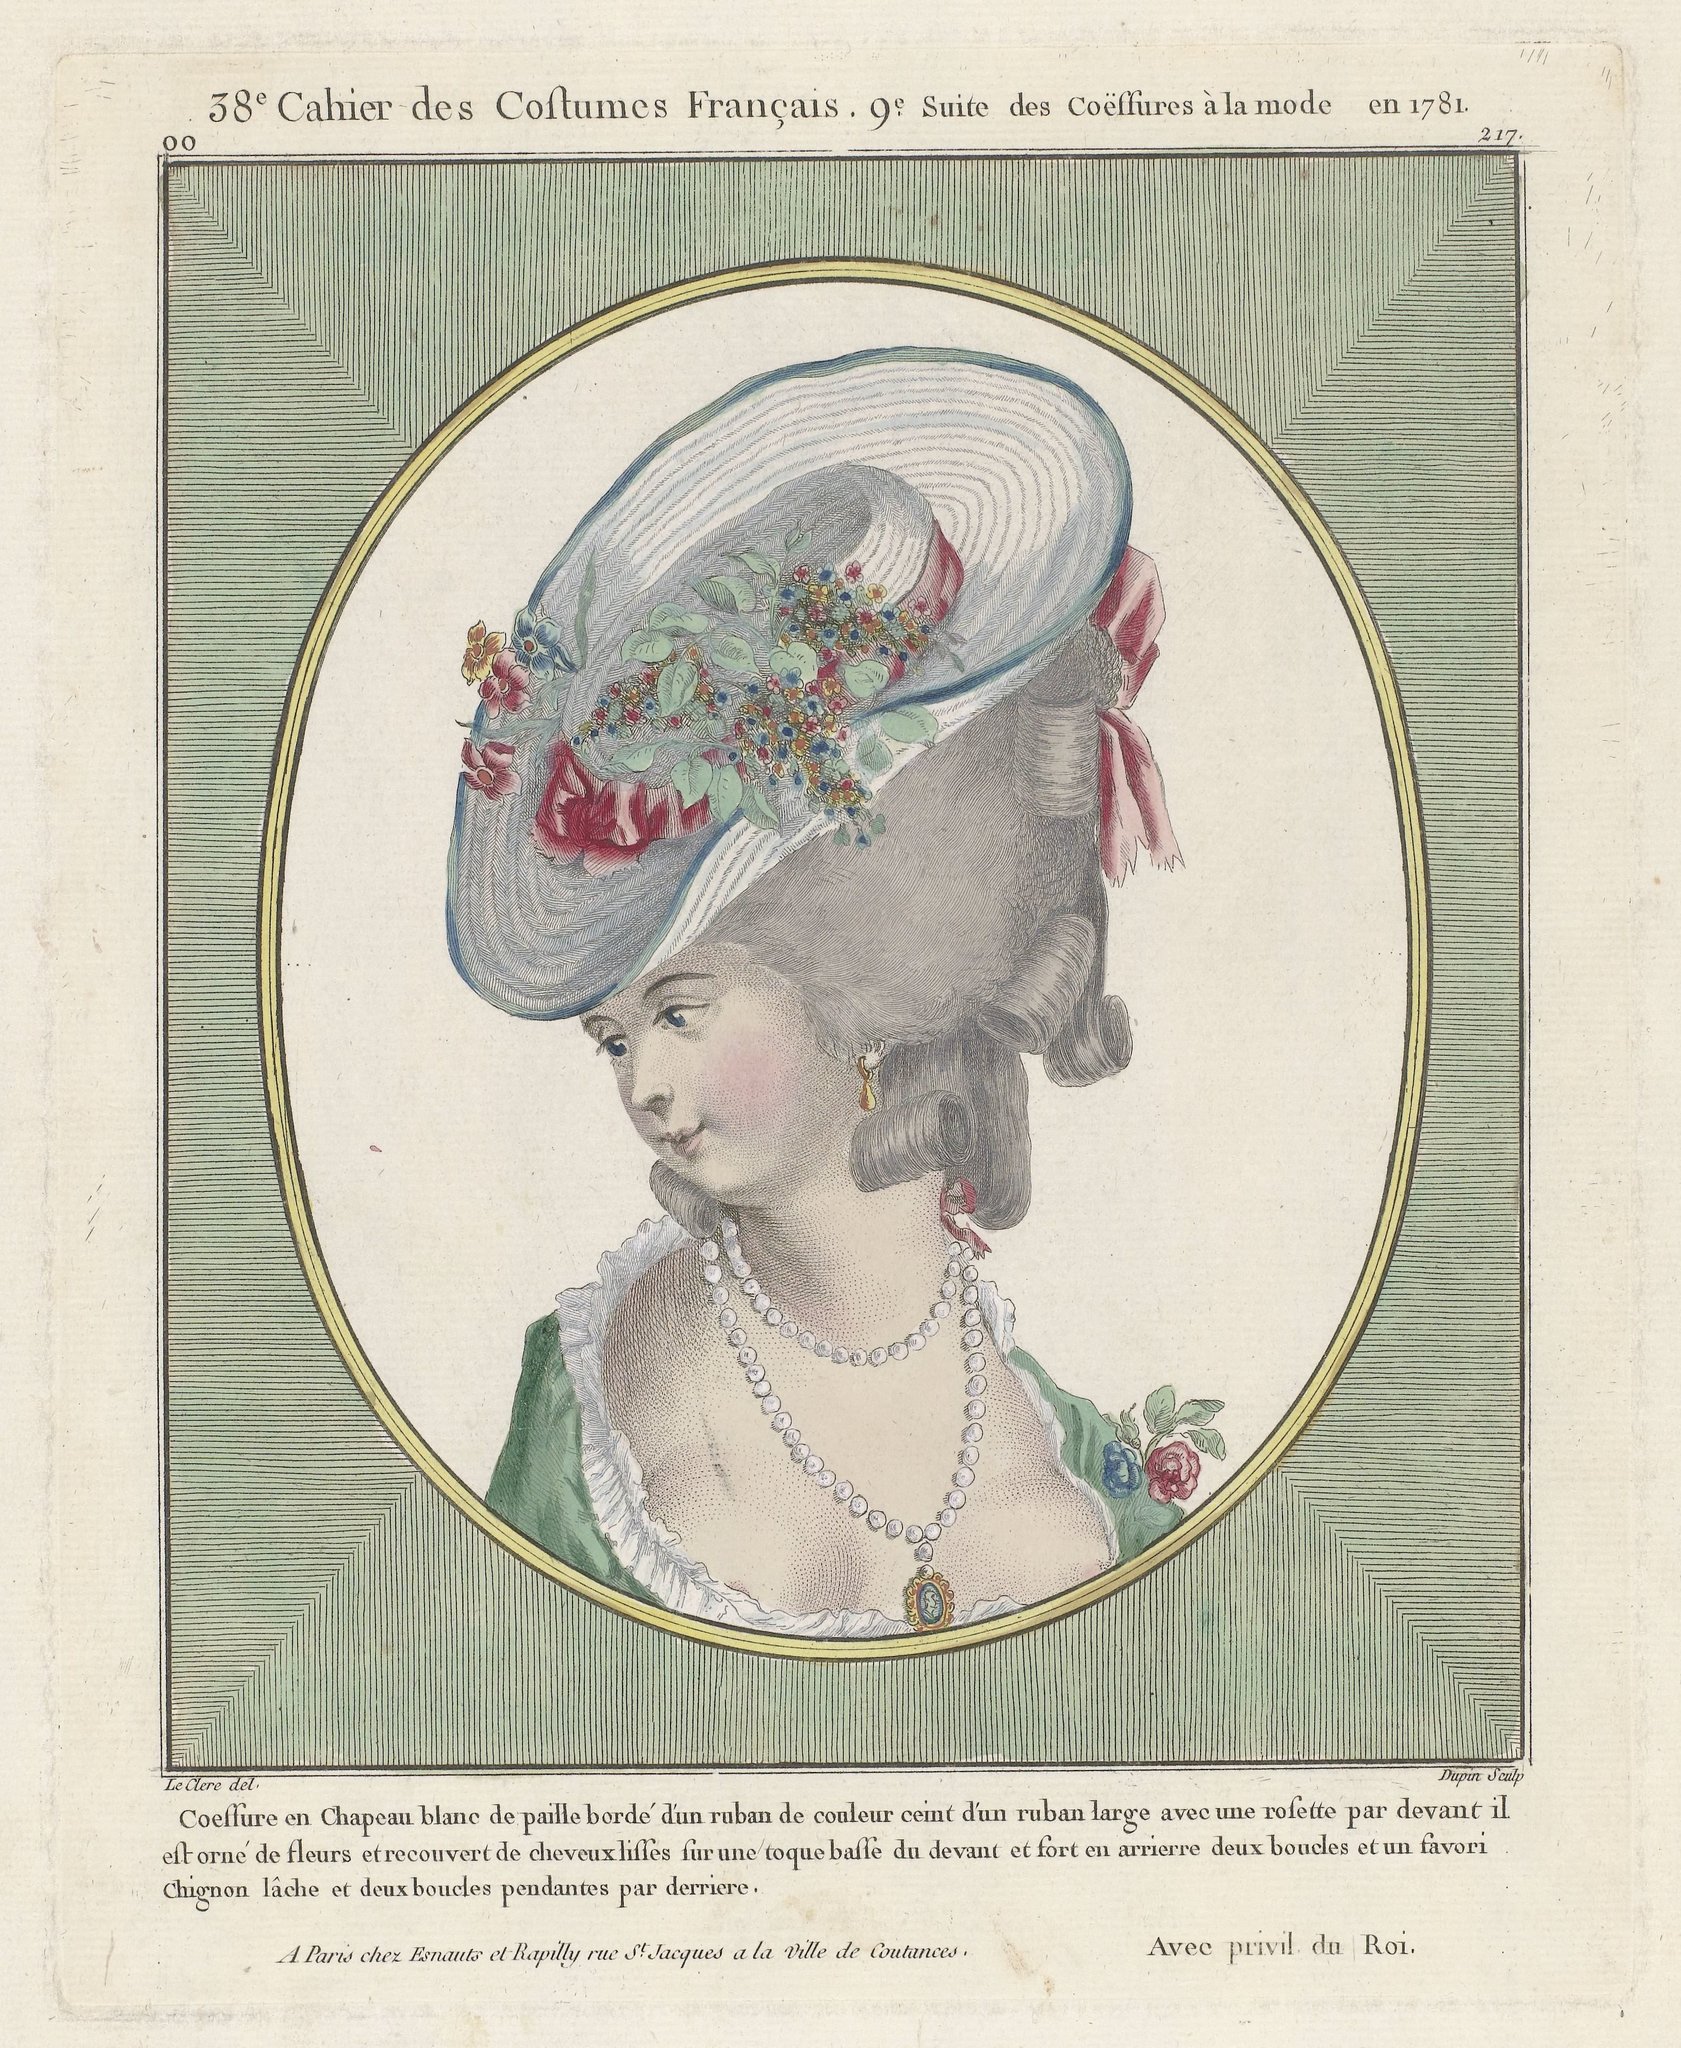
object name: fashion print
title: Coeffure en Chapeau blanc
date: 1781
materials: paper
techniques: engraving, hand coloring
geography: paris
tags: corsage (+ women's clothes), ear-rings (+ women's clothes), border, ribbon, braid (+ women's clothes), head-gear (straw hat) (+ women's clothes), styles of hairdress - aa - ~ women, fashion plates, pearl; pearl necklace (+ women's clothes)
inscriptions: caption: ‘Coeffure en Chapeau blanc de paille bordé d'un ruban de couleur ceint d'un ruban large avec une rosette par devant il est orné de fleurs et recouvert de cheveux lisses sur une toque basse du devant et fort en arrierre deux boucles et un favori Chignon lâche et deux boucles pendantes par derriere.’, title: ‘38e Cahier des Costumes Français.9e Suite des Coëffures à la mode en 1781’, address: ‘A Paris chez Esnauts et Rapilly rue St. Jacques a la Ville de Coutances. Avec privil. du Roi.’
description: While this print is actually all about the lady’s coiffure, her jewellery is just as interesting. Her plain gold earrings differ greatly from the large gemstone-set variations popular earlier in the 18th century. Hanging from the strand of pearls is a portrait medallion with either a likeness of a loved one or possibly a cameo from classical antiquity.